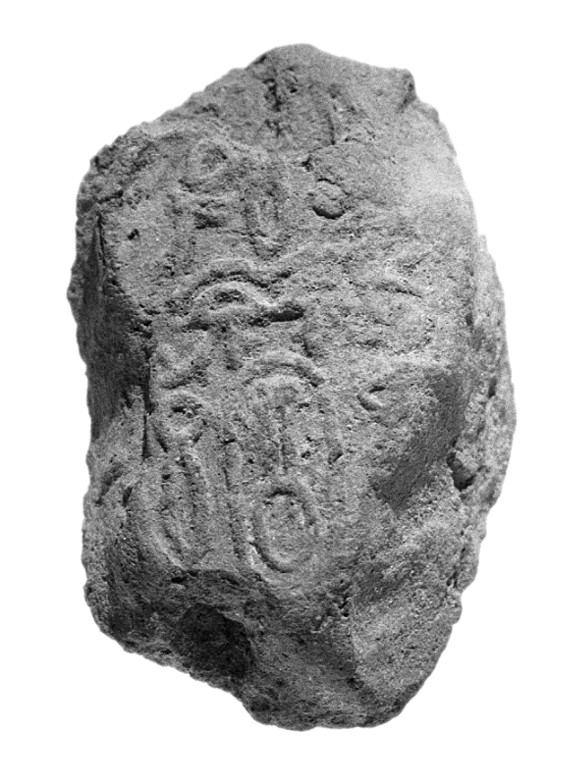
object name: sealing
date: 1981-1640 BCE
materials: mud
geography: egypt